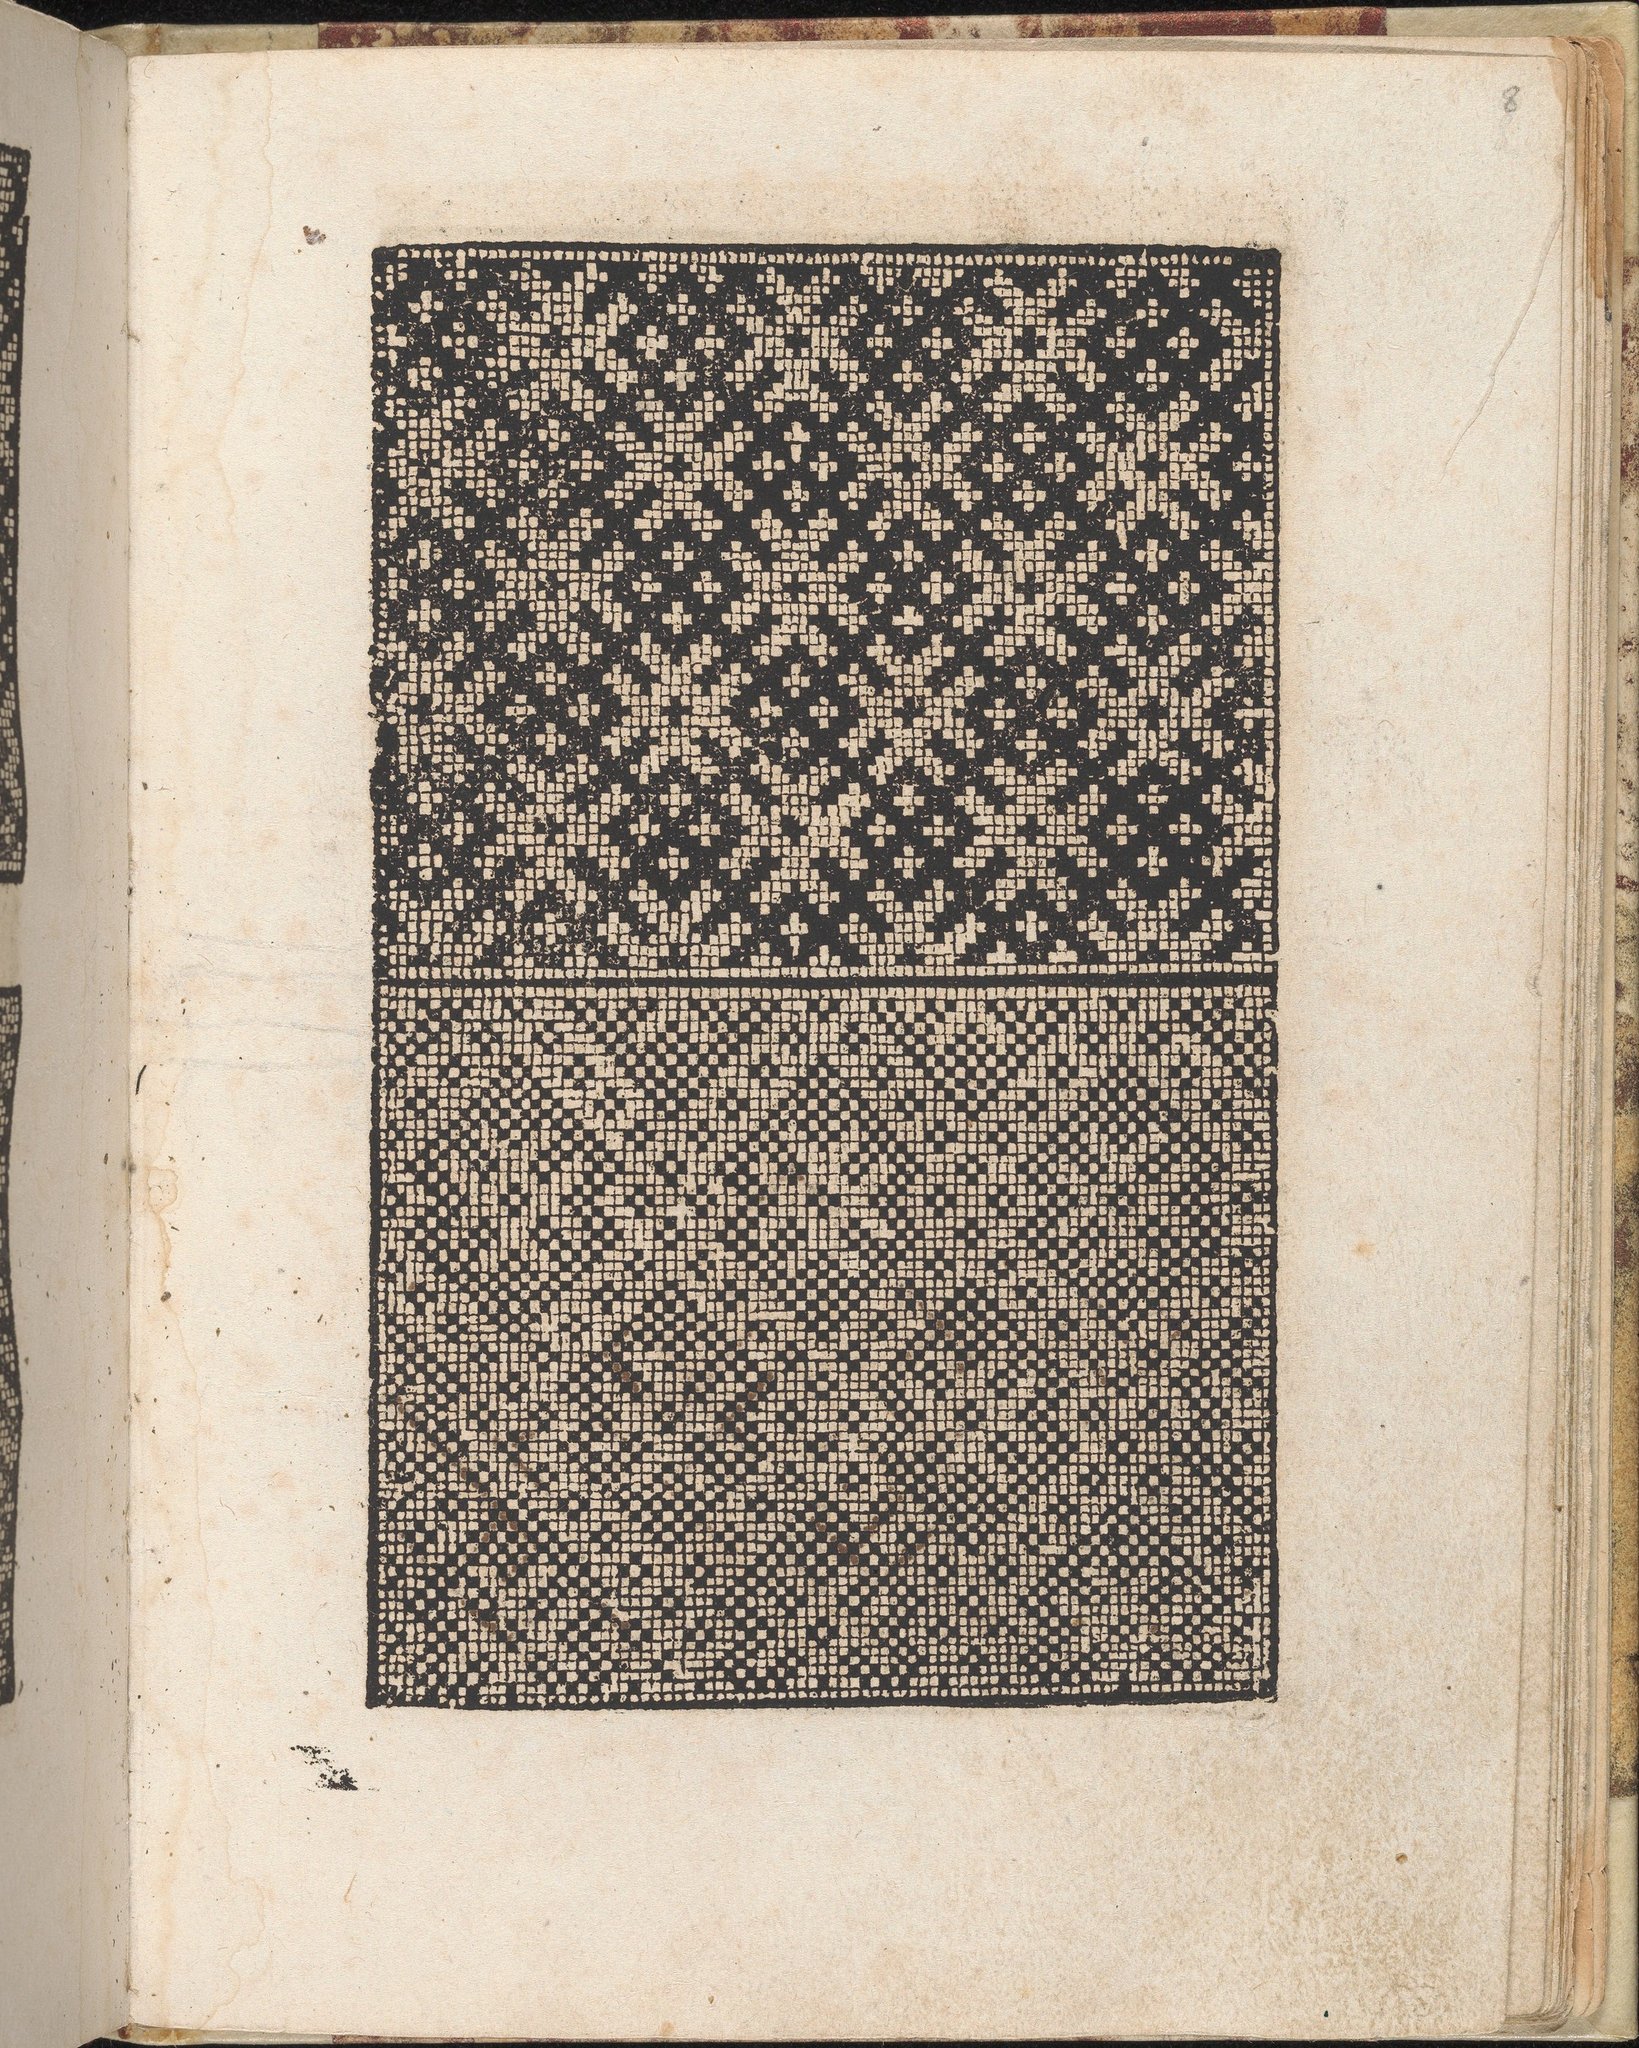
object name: book print ornament architecture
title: Ein new getruckt model Büchli...Page 7, verso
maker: johann schönsperger the younger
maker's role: publisher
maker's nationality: german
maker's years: 1490-1550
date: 1529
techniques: woodcut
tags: ornament